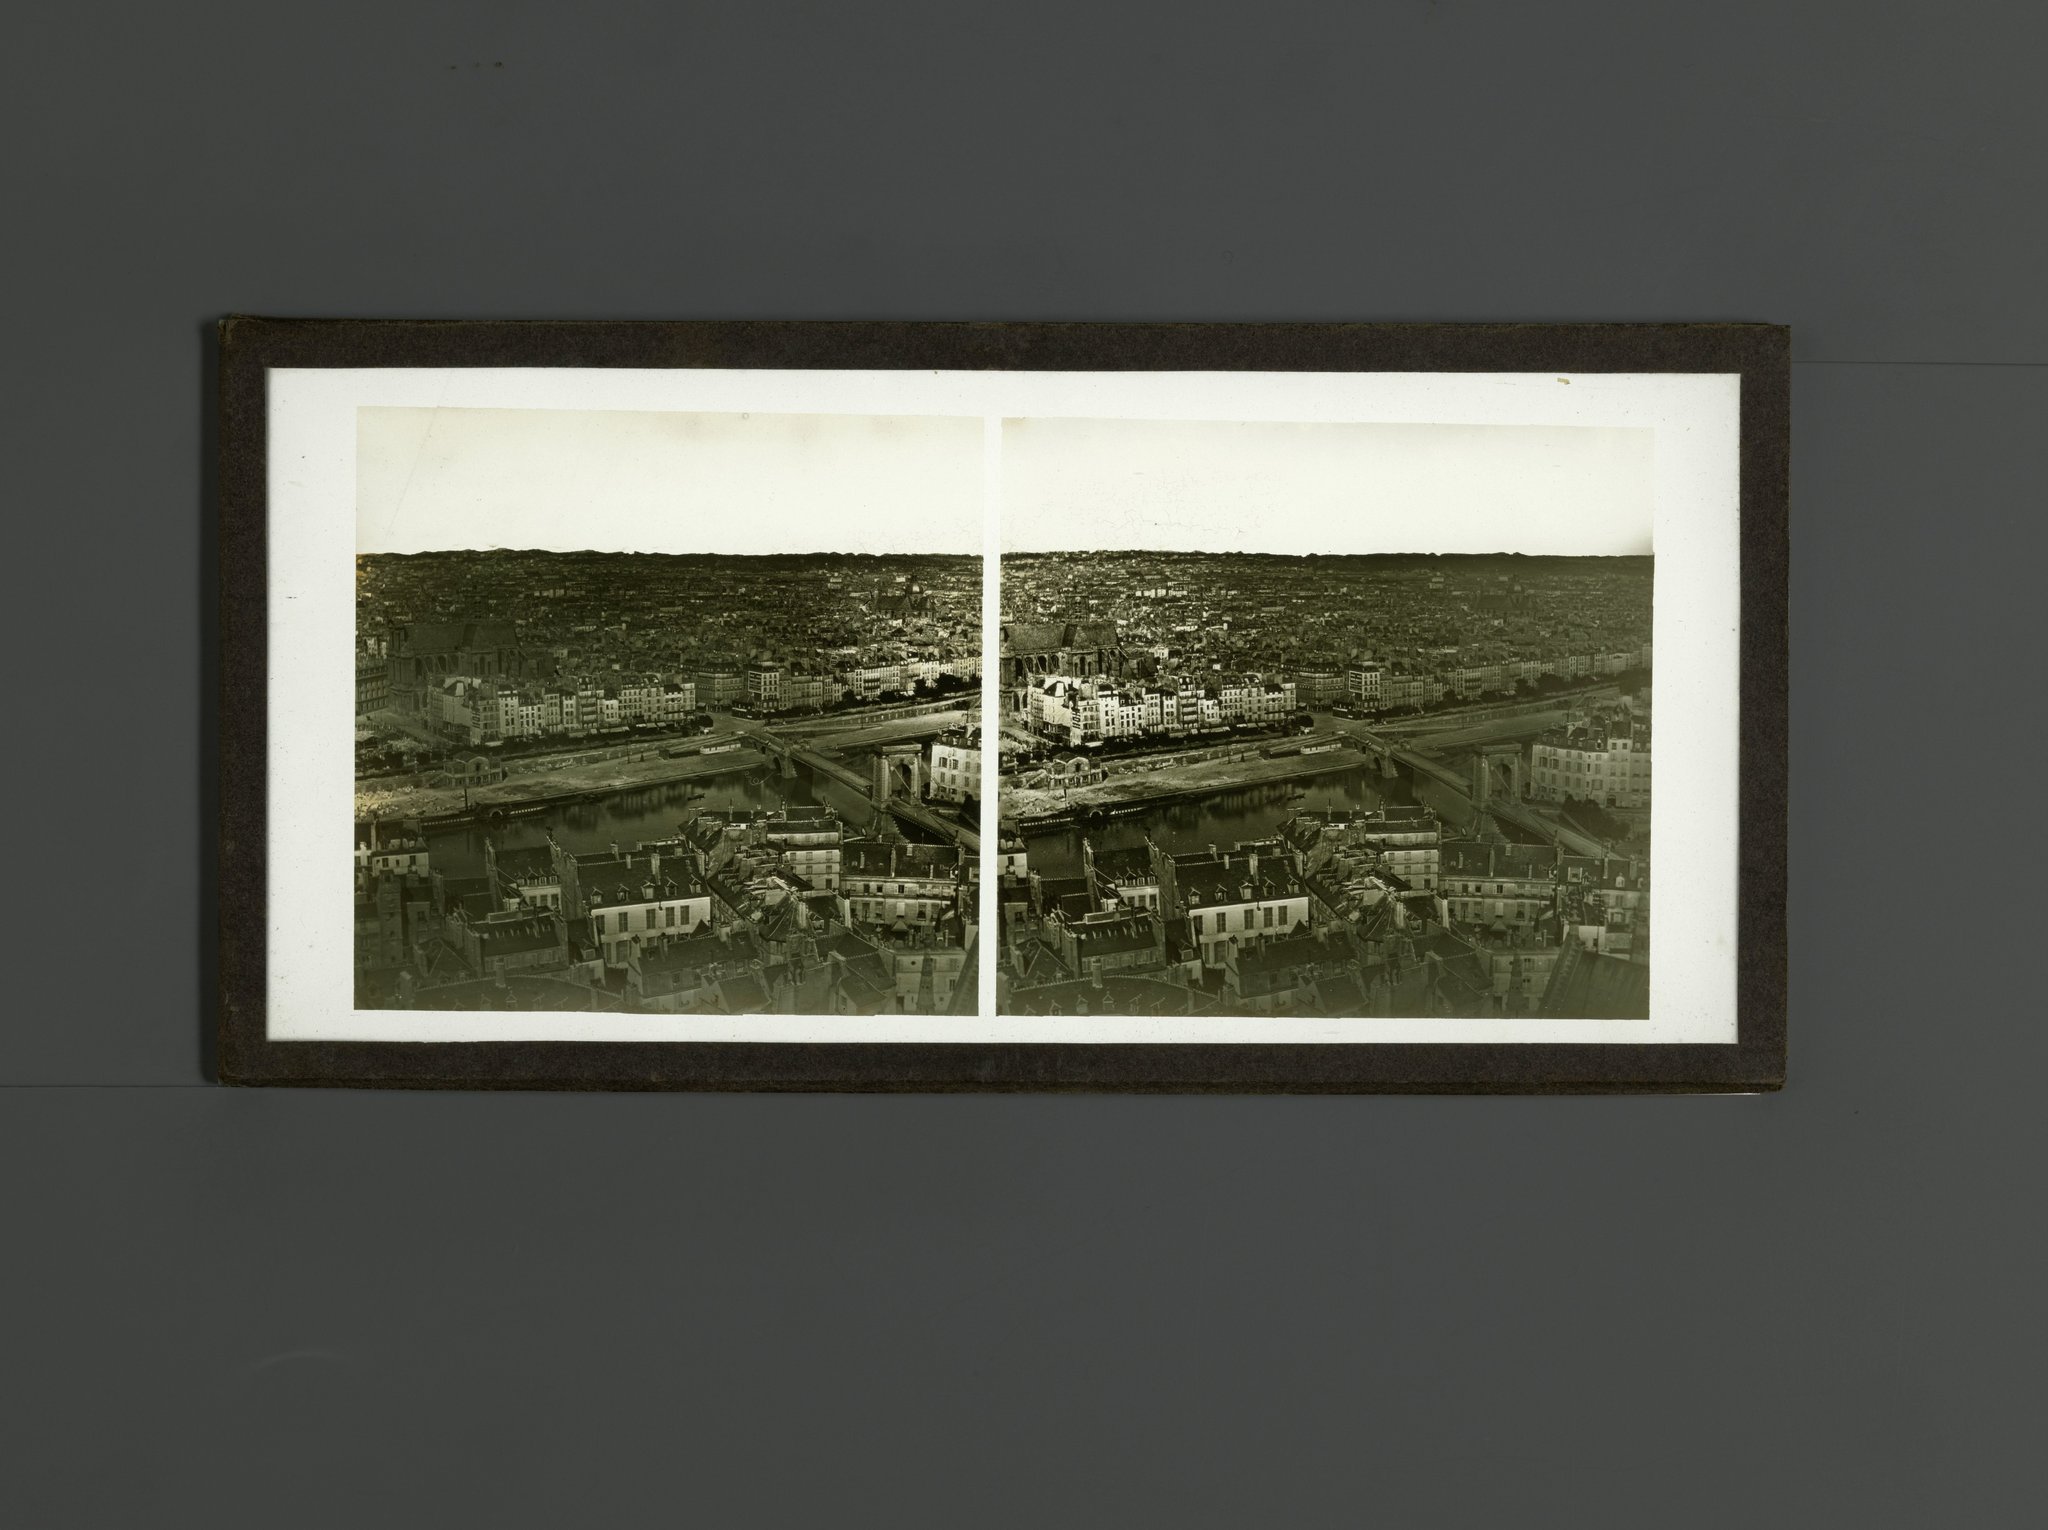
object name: stereoscopic photograph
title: Gezicht op Parijs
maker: Anonymous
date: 1856-1890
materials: glass, paper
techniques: slide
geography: paris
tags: city-view in general; 'veduta', paris